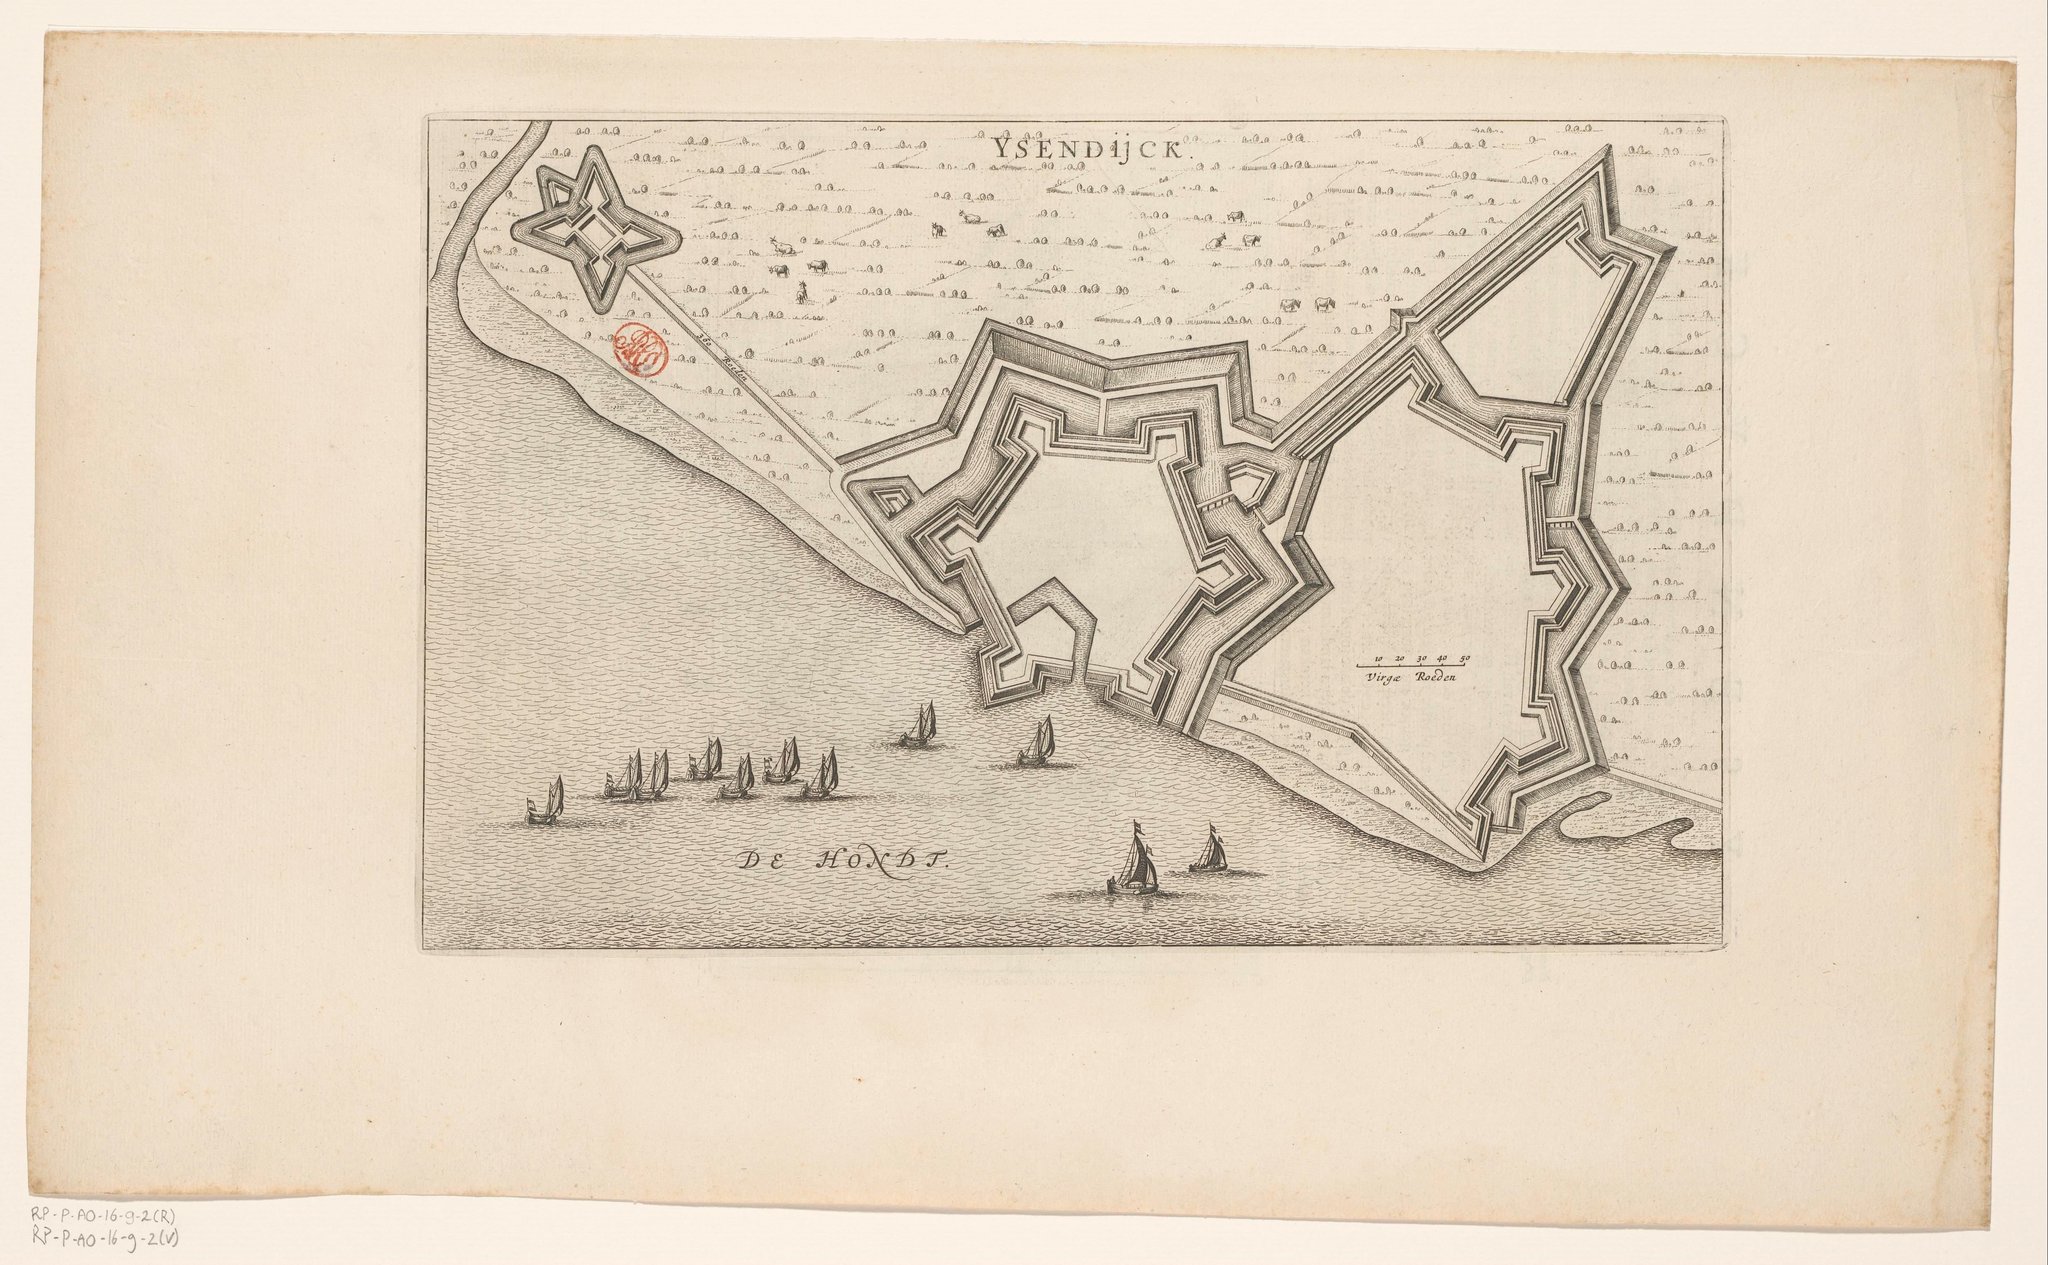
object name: area plan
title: Vestingplattegrond van IJzendijke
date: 1652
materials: paper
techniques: engraving, etching, letterpress printing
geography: amsterdam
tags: fortified city, maps of cities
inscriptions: collector's mark: Lugt 195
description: Prent gebruikt in: Blaeu, Johannes Willemszoon. Toonneel der steden van de Vereenighde Nederlanden. 2 delen. Amsterdam: Johannes Willemszoon Blaeu, 1652, dl. 1.